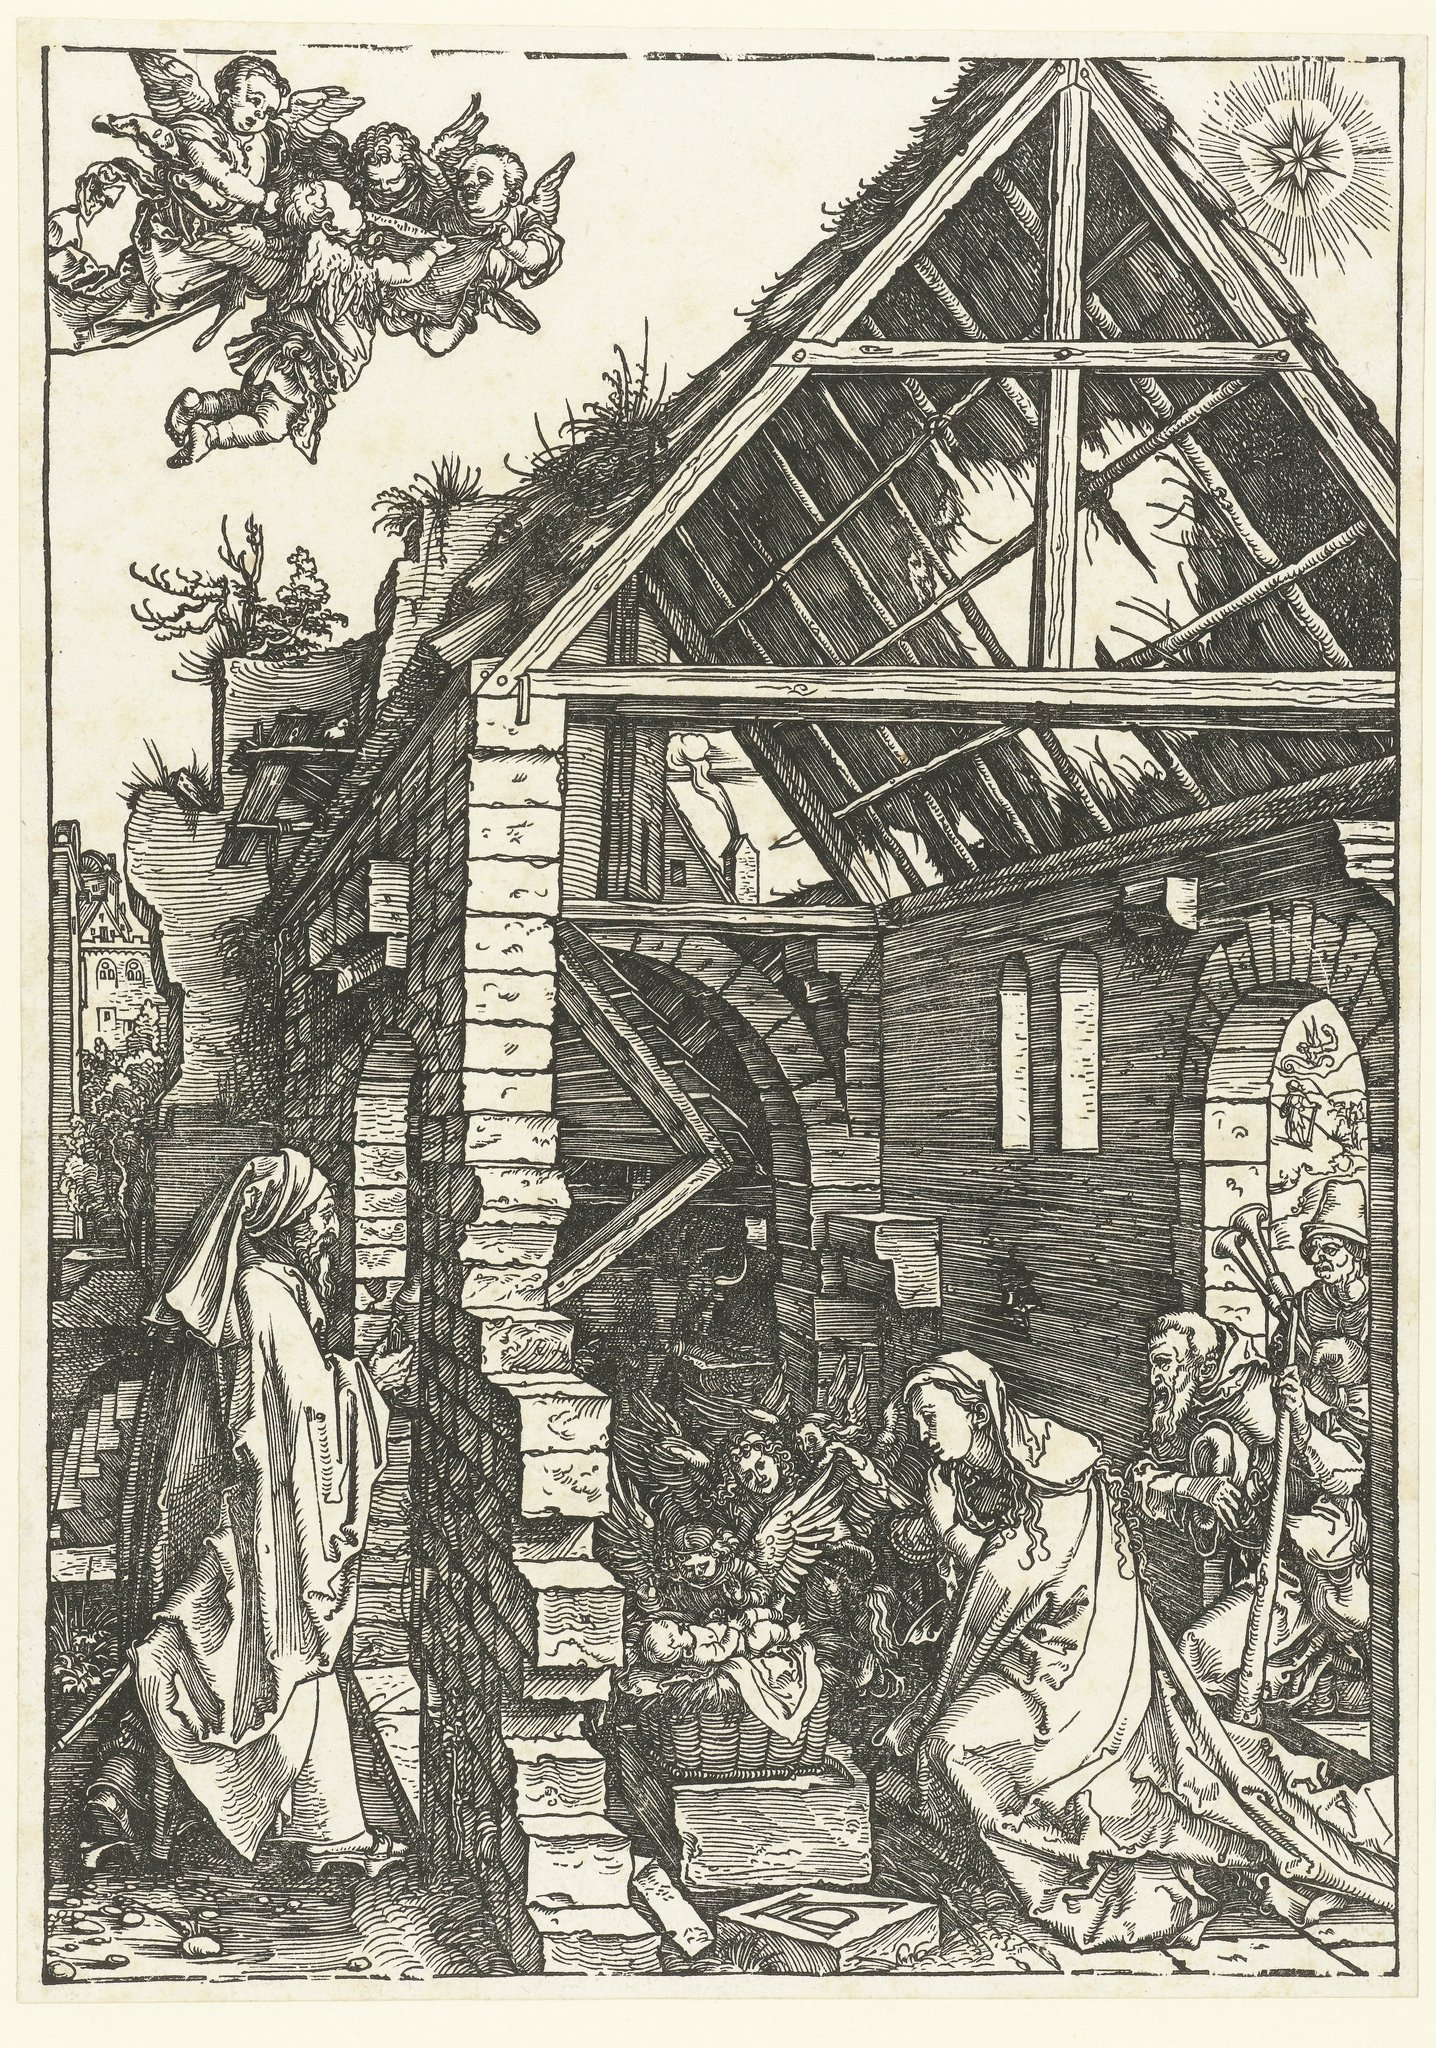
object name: print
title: Aanbidding door de herders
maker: albrecht dürer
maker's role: draughtsman, painter, print maker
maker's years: 1471-1528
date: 1502-1503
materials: paper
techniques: woodcut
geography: nuremberg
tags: adoration of the christ-child by the shepherds; mary and joseph present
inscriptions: inscription: ‘Geoffreerd aan de Teken Akademie / der stadt Amsterdam / 1788 P...’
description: In een vervallen huis knielt Maria bij haar kind. Engeltjes staan naast haar. Herders komen door een deur achter haar binnen, Jozef door een deur voor haar. Deze prent is onderdeel van een serie van 20 prenten, bestaand uit een titelprent en 19 prenten met scènes uit het leven van Maria.